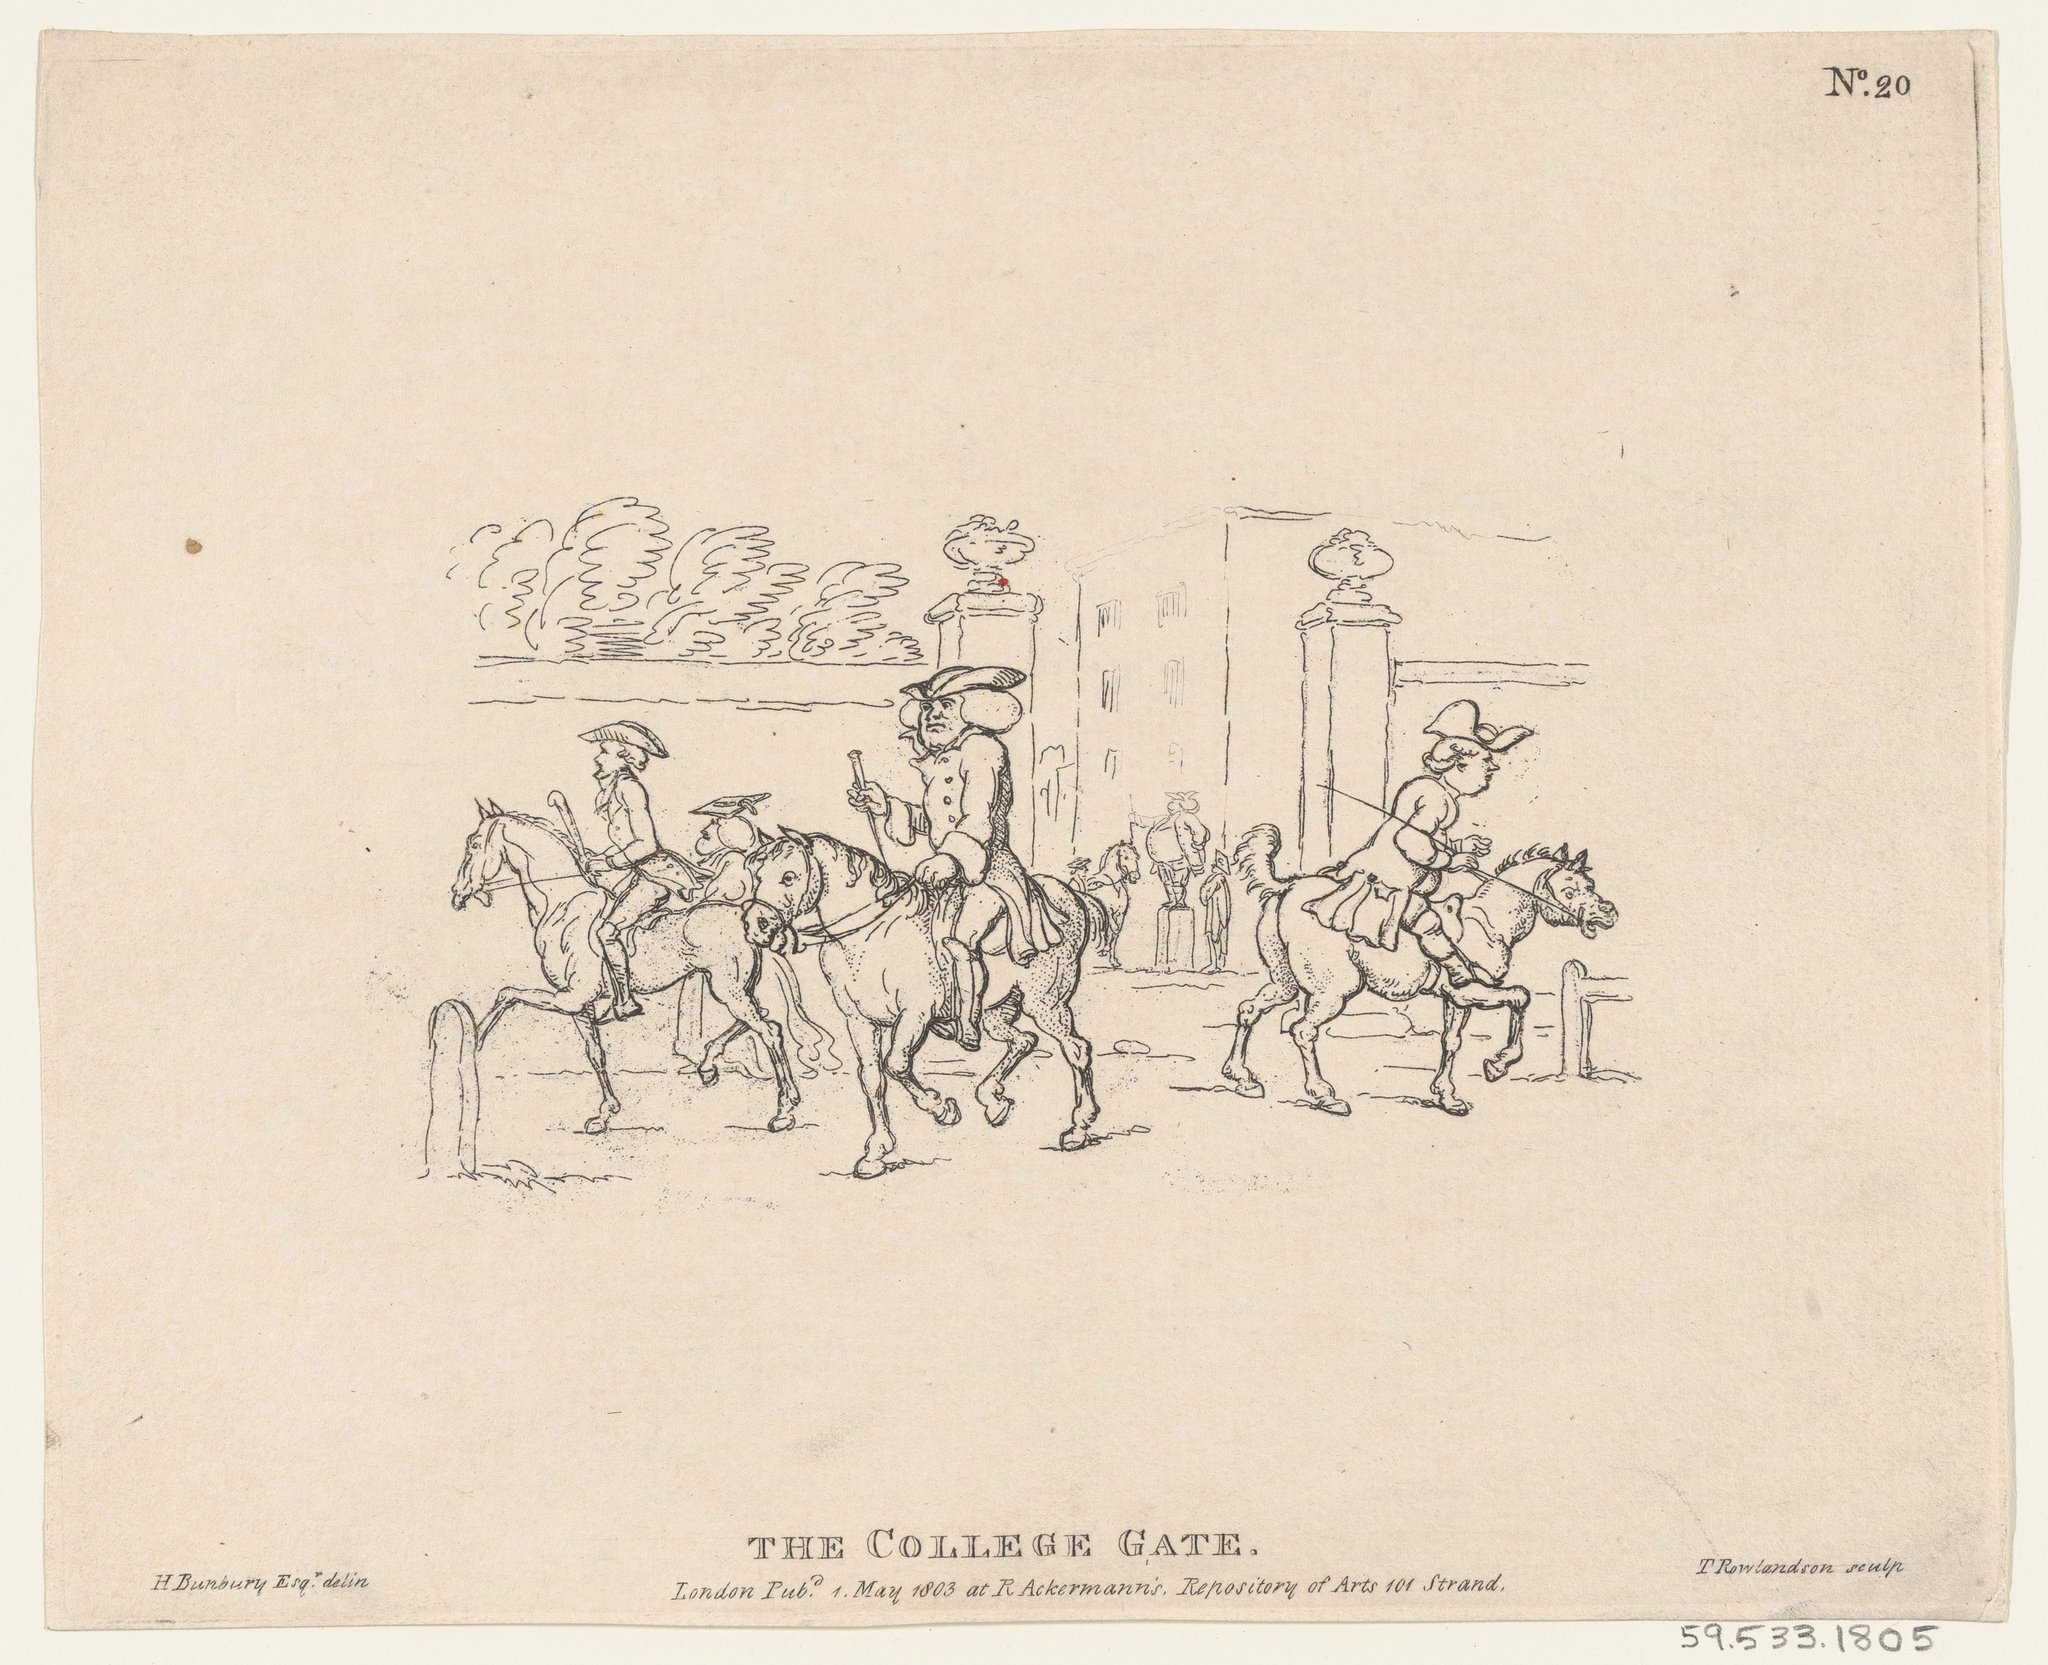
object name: print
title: The College Gate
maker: thomas rowlandson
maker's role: artist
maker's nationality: british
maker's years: 1757-1827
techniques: etching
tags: men,horses